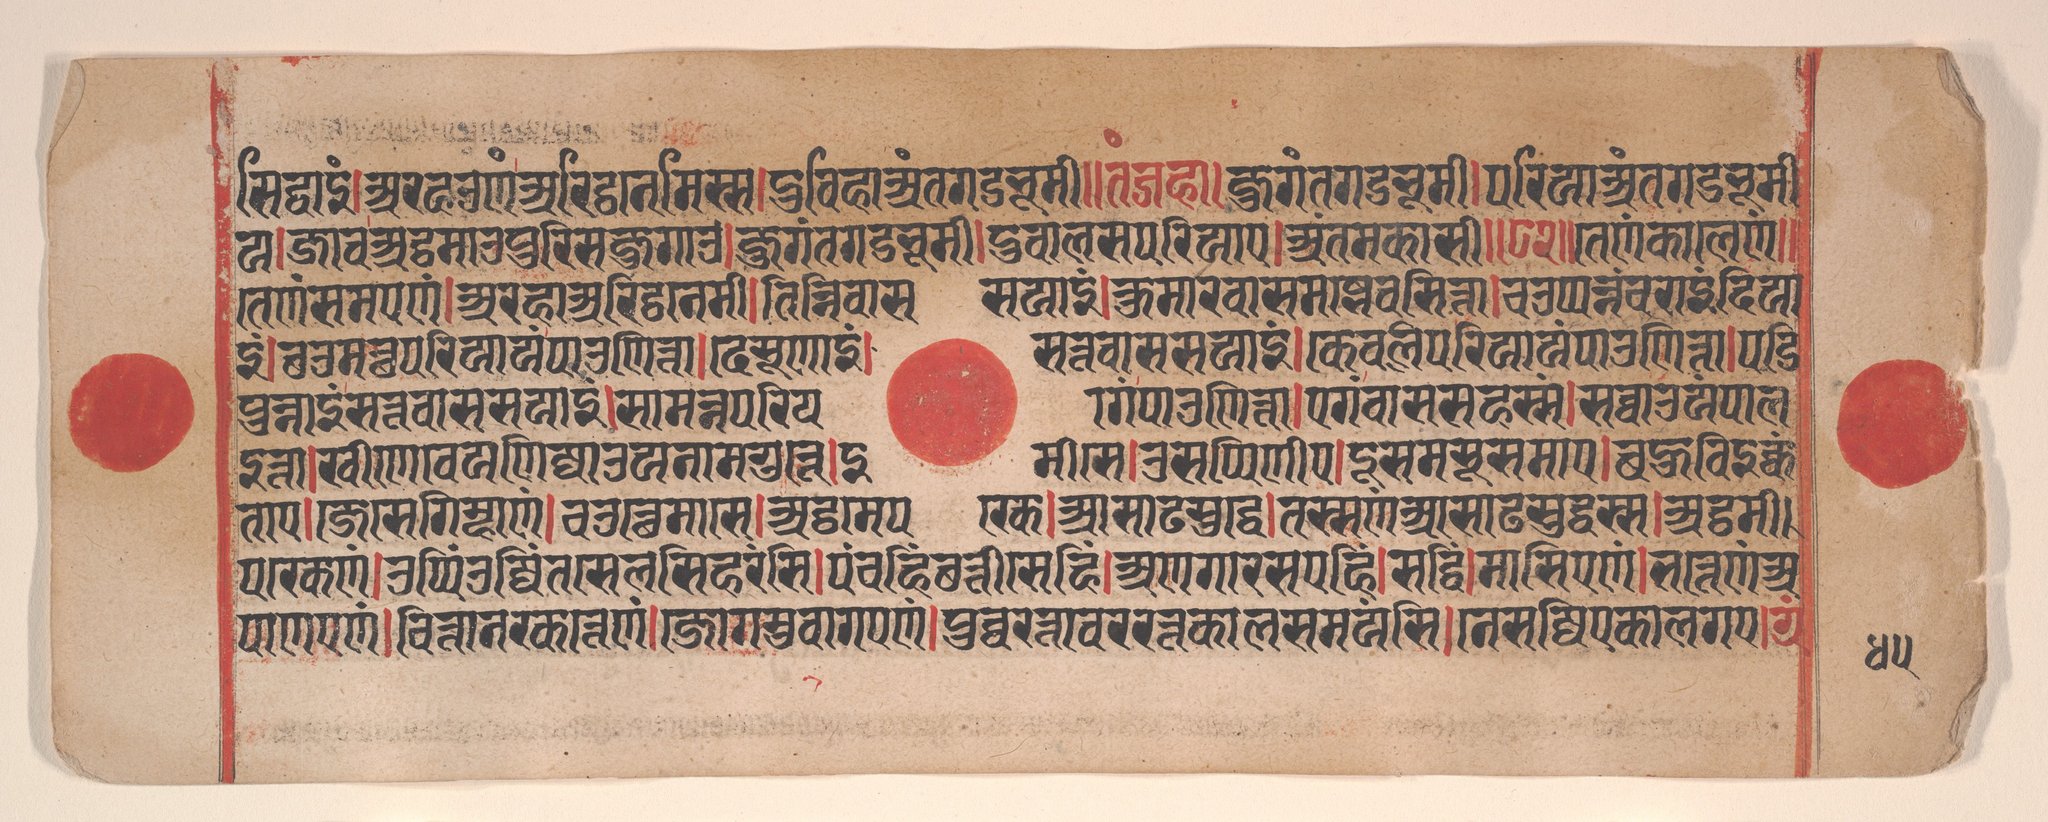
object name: folio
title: Leaf from a Kalpa Sutra (Jain Book of Rituals)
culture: indian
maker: bhadrabahu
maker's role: artist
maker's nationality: indian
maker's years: 356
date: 1401-1500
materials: gold, ink, paper, watercolor